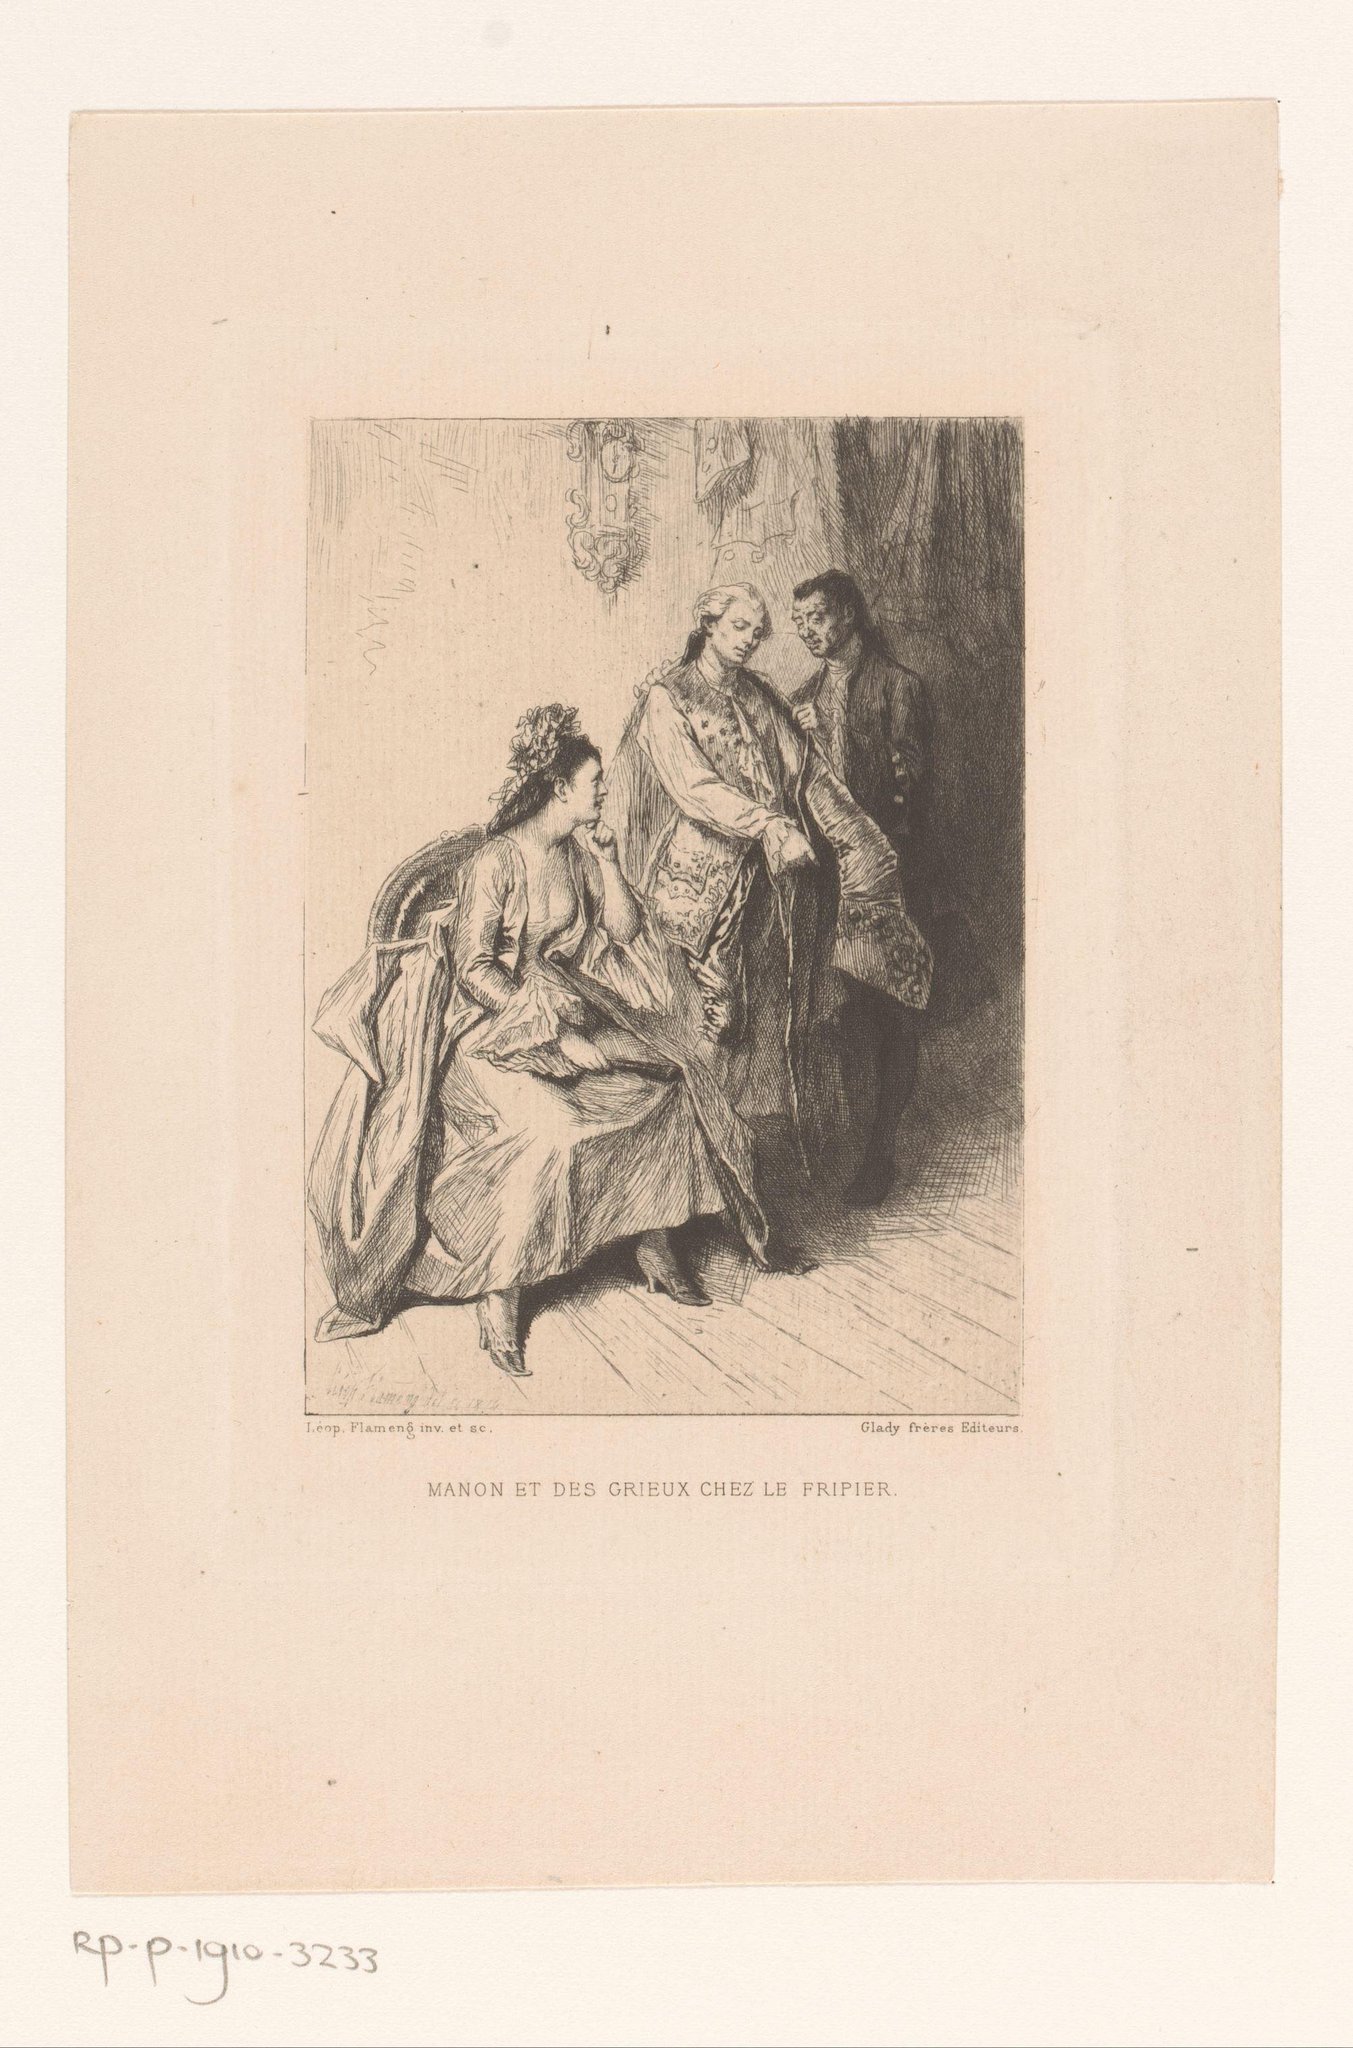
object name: print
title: Manon Lescaut en Chevalier des Grieux bij de verkoper van tweedehands kleding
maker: léopold flameng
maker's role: print maker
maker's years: 1831-1911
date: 1875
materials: paper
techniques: etching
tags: clothes, costume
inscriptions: collector's mark: Lugt 2228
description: Prent uit: Prévost, Antoine François. Histoire de Manon Lescaut et du Chevalier Des Grieux (...). Paris: Glady frères, 1875.